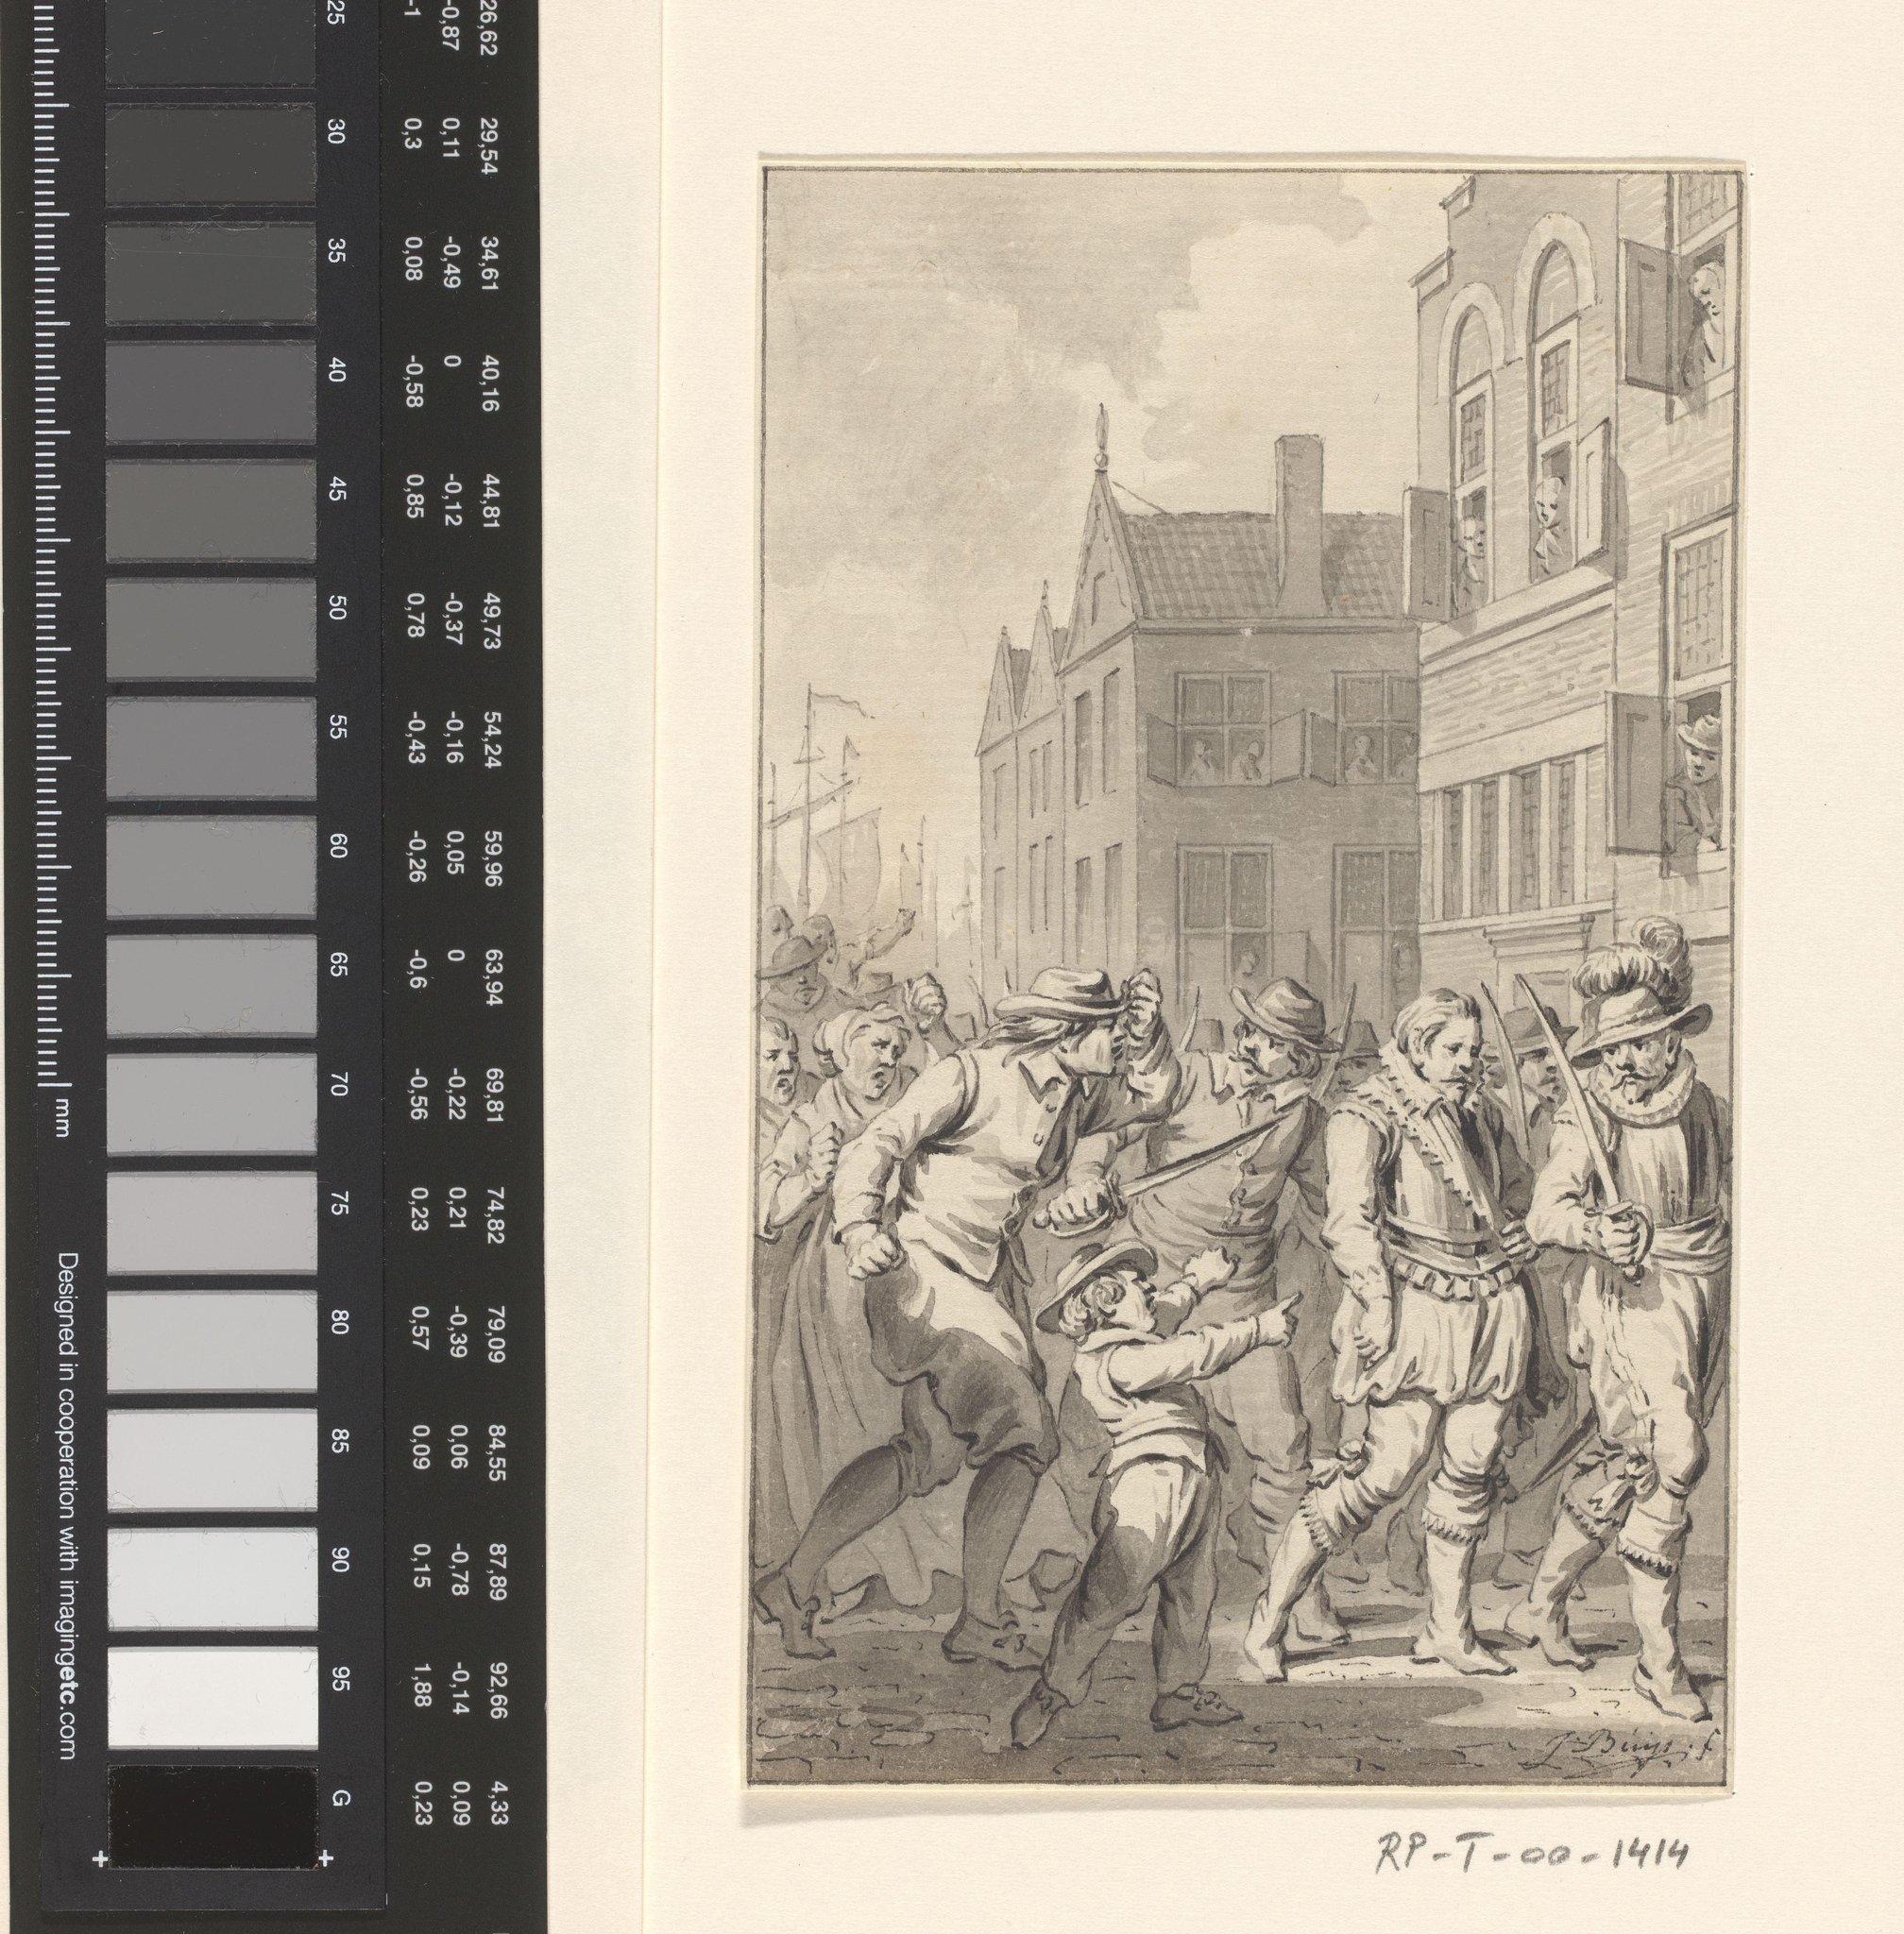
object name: historieplaat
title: Maximilien de Hénin-Lietard, graaf van Bossu, als krijgsgevangene in Hoorn binnengevoerd, oktober 1573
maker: jacobus buys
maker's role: draughtsman, print maker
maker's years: 1724-1801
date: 1785-1787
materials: ink, paper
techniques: brush, pen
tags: antwerp, earl, historical persons, prisoner of war (after the battle), historical events and situations, hoorn (north holland)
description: Maximiliaan de Hennin, graaf van Bossu als krijgsgevangene Hoorn binnen gebracht, oktober 1573. De graaf wordt op straat door omstanders uitgejouwd en bespot. Ontwerp voor een prent.